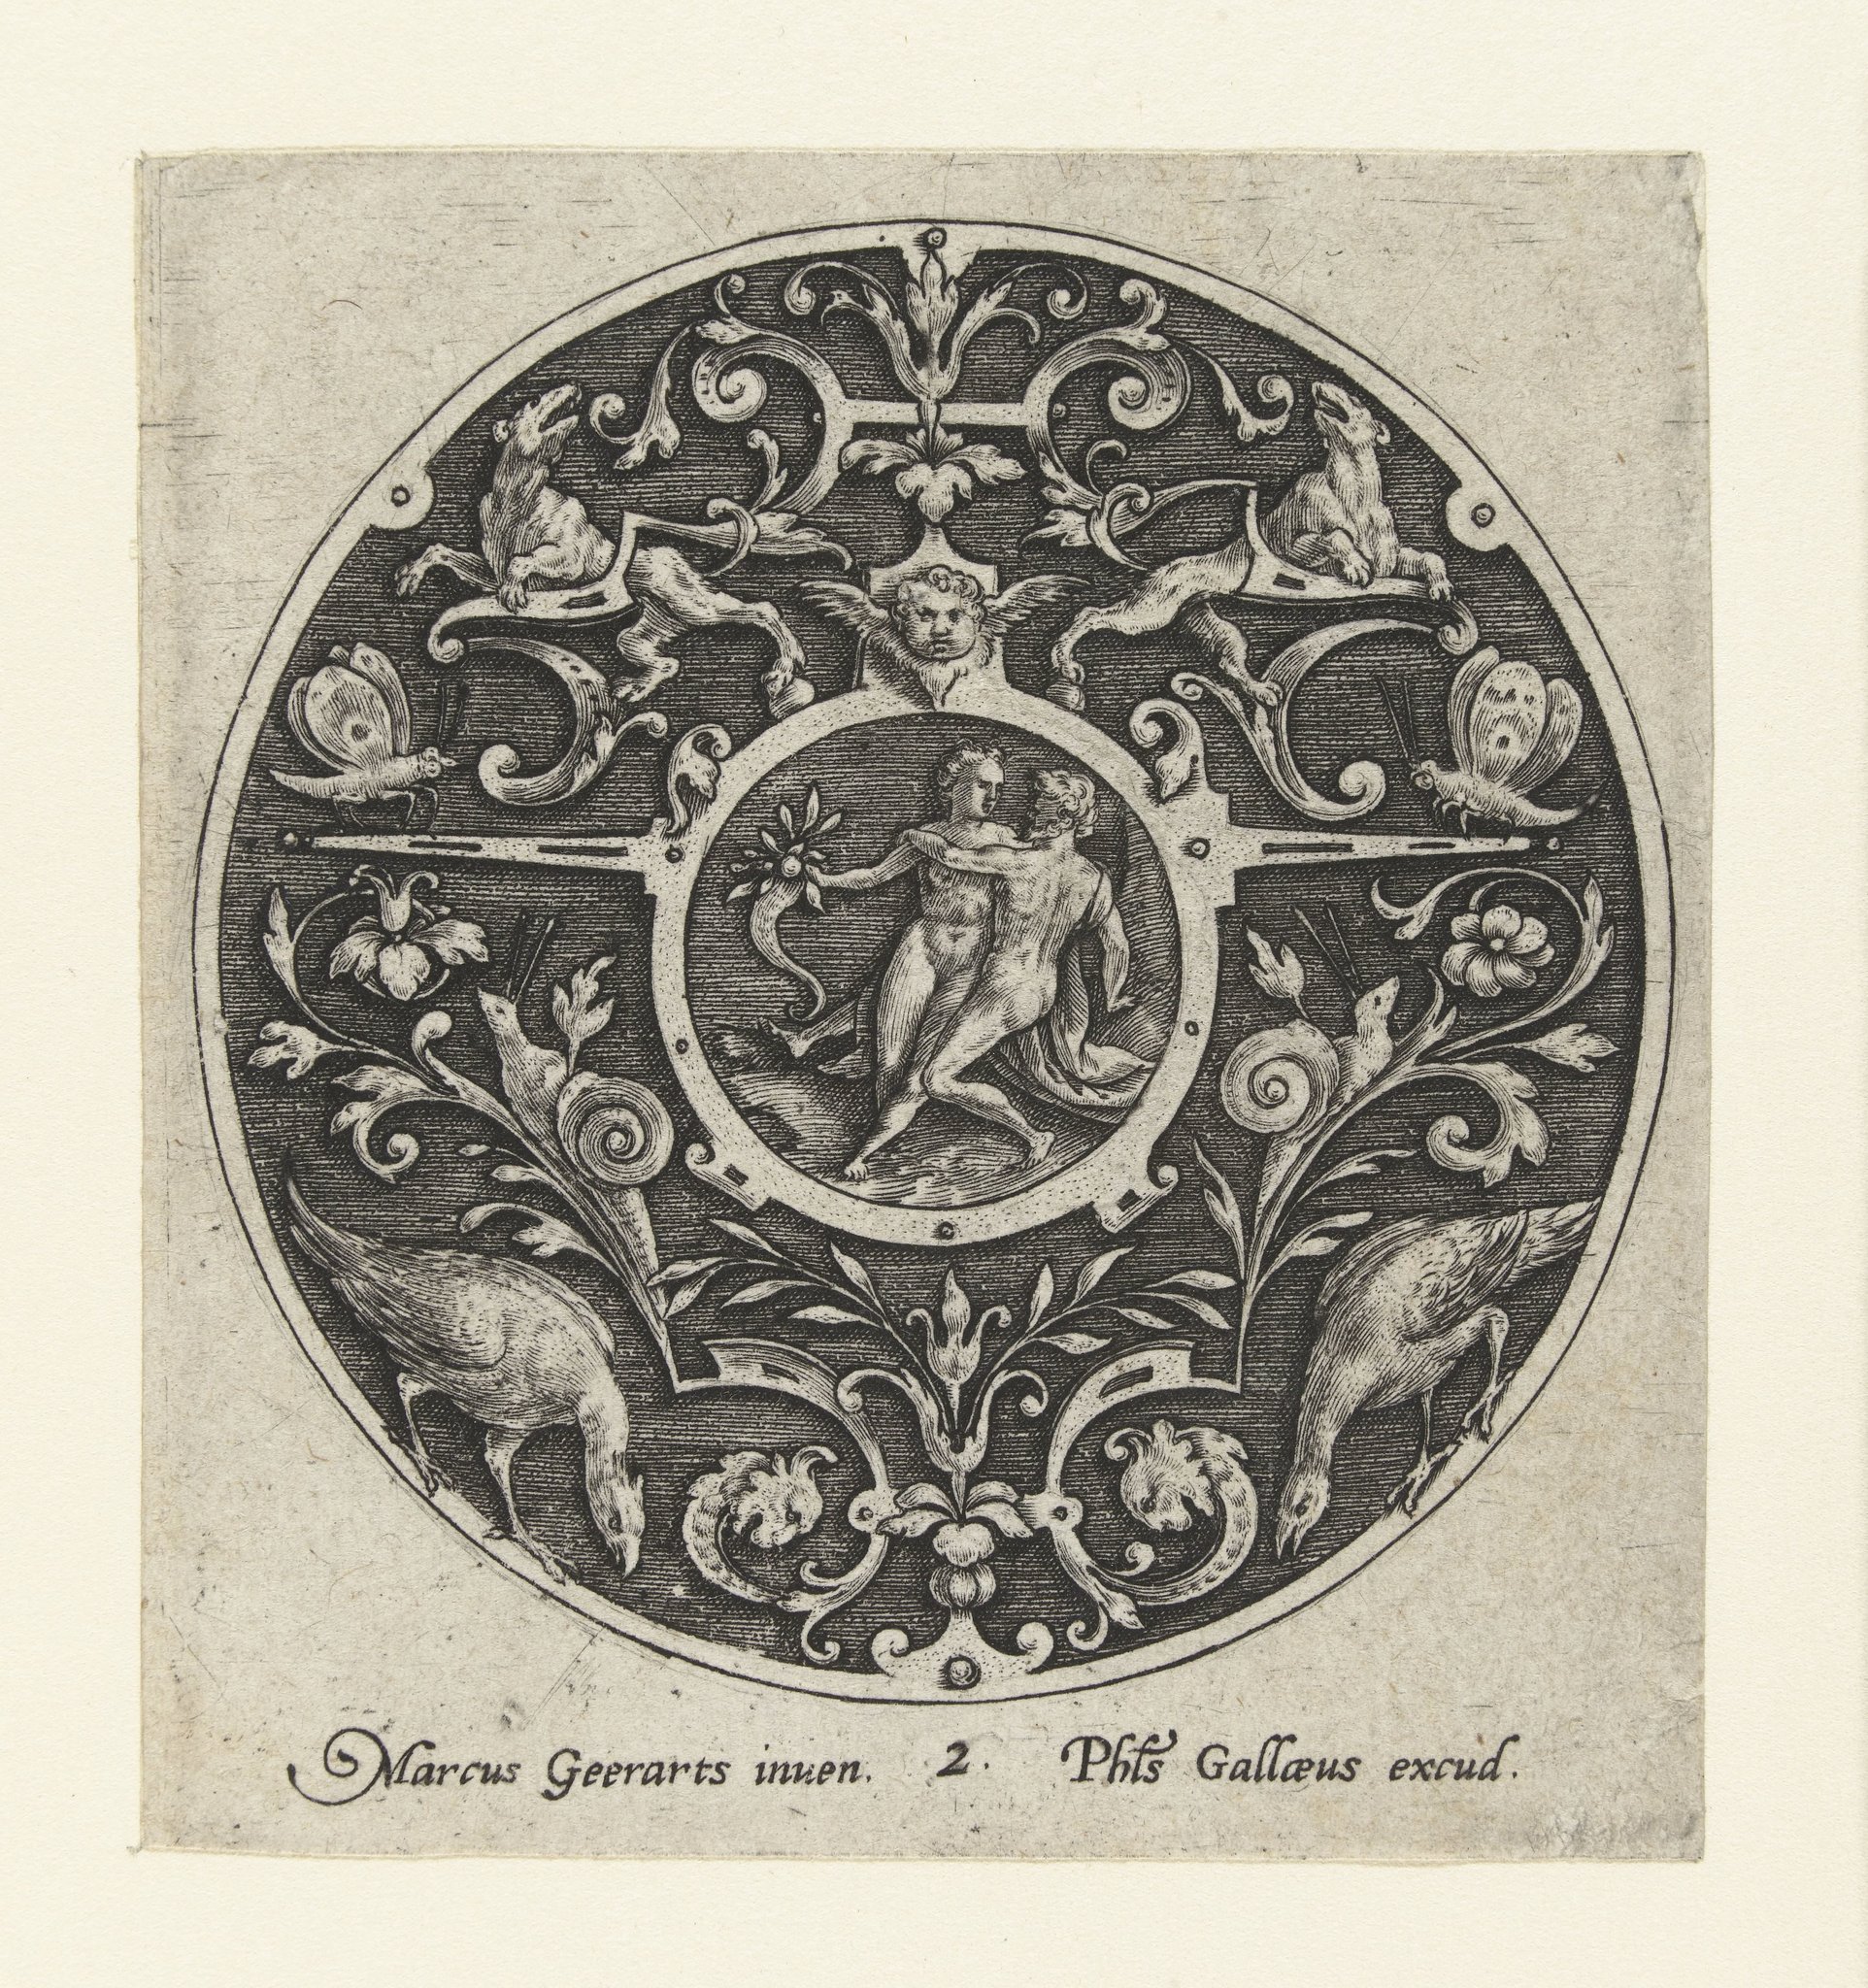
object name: ornament print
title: Rond ornament, in een medaillon in het midden zit een paar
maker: philips galle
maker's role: print maker, publisher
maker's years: 1537-1612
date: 1547-1612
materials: paper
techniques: engraving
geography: netherlands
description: Blad 2 van 5 genummerde bladen uit een serie van 12. Rond het medaillon loopt een rand van grotesken met onderaan twee vogels en twee slakken.